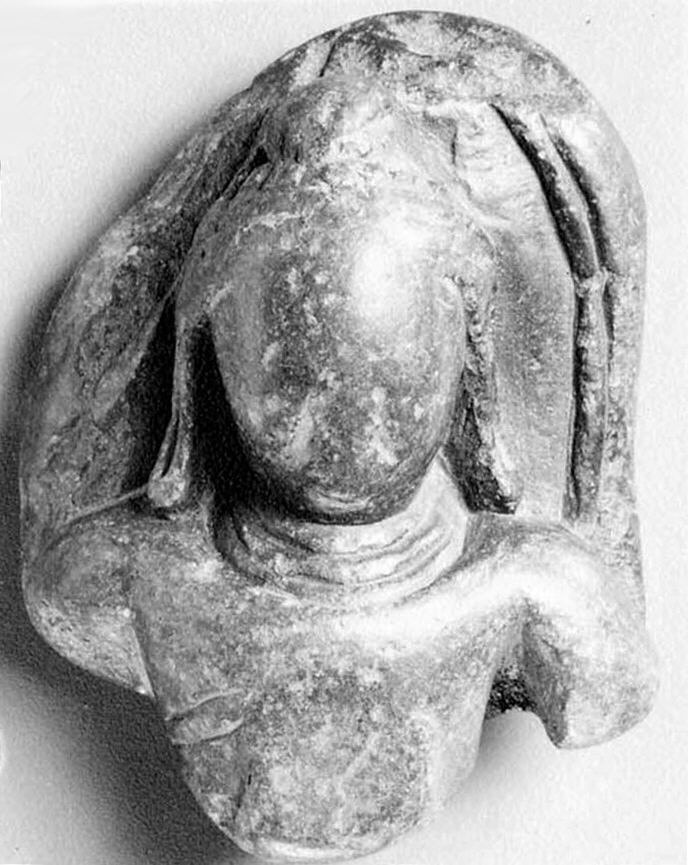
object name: bust fragment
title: Fragment of a Bust of Buddha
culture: kashmiri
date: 701-800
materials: stone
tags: kashmir,buddhism,buddha